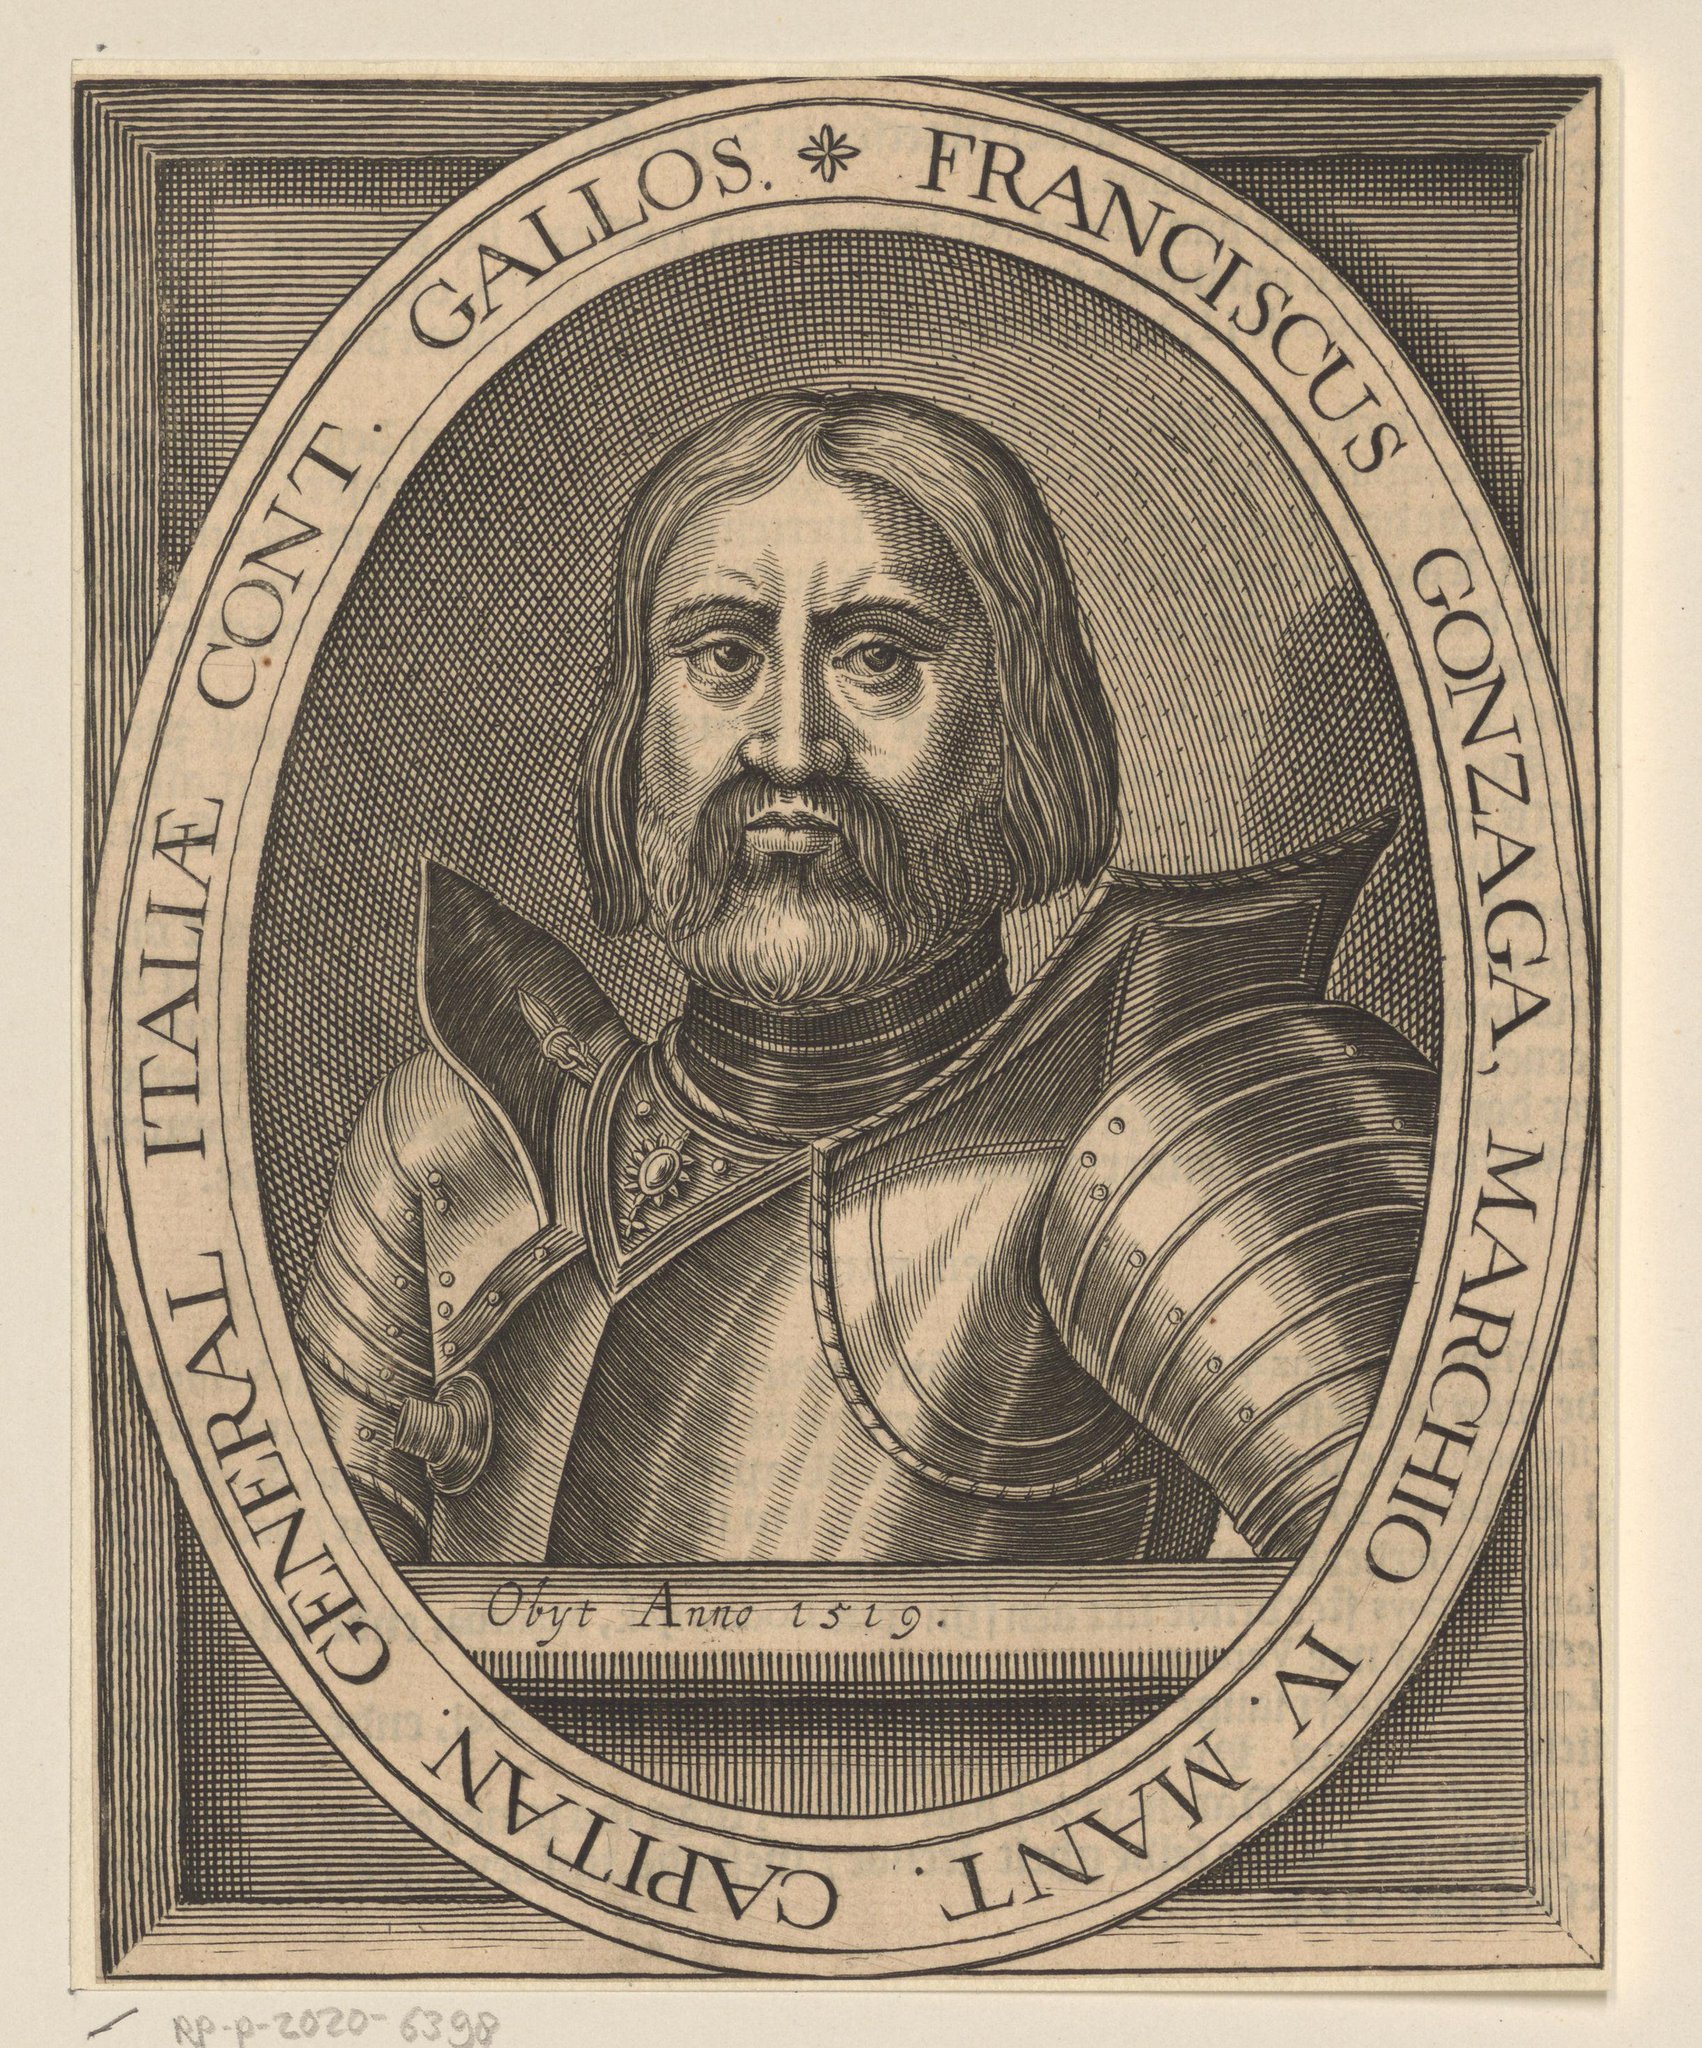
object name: print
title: Portret van Francesco (II) Gonzaga, markgraaf van Mantua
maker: Anonymous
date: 1600-1700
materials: paper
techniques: engraving, letterpress printing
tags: commander-in-chief, general, marshal, historical persons